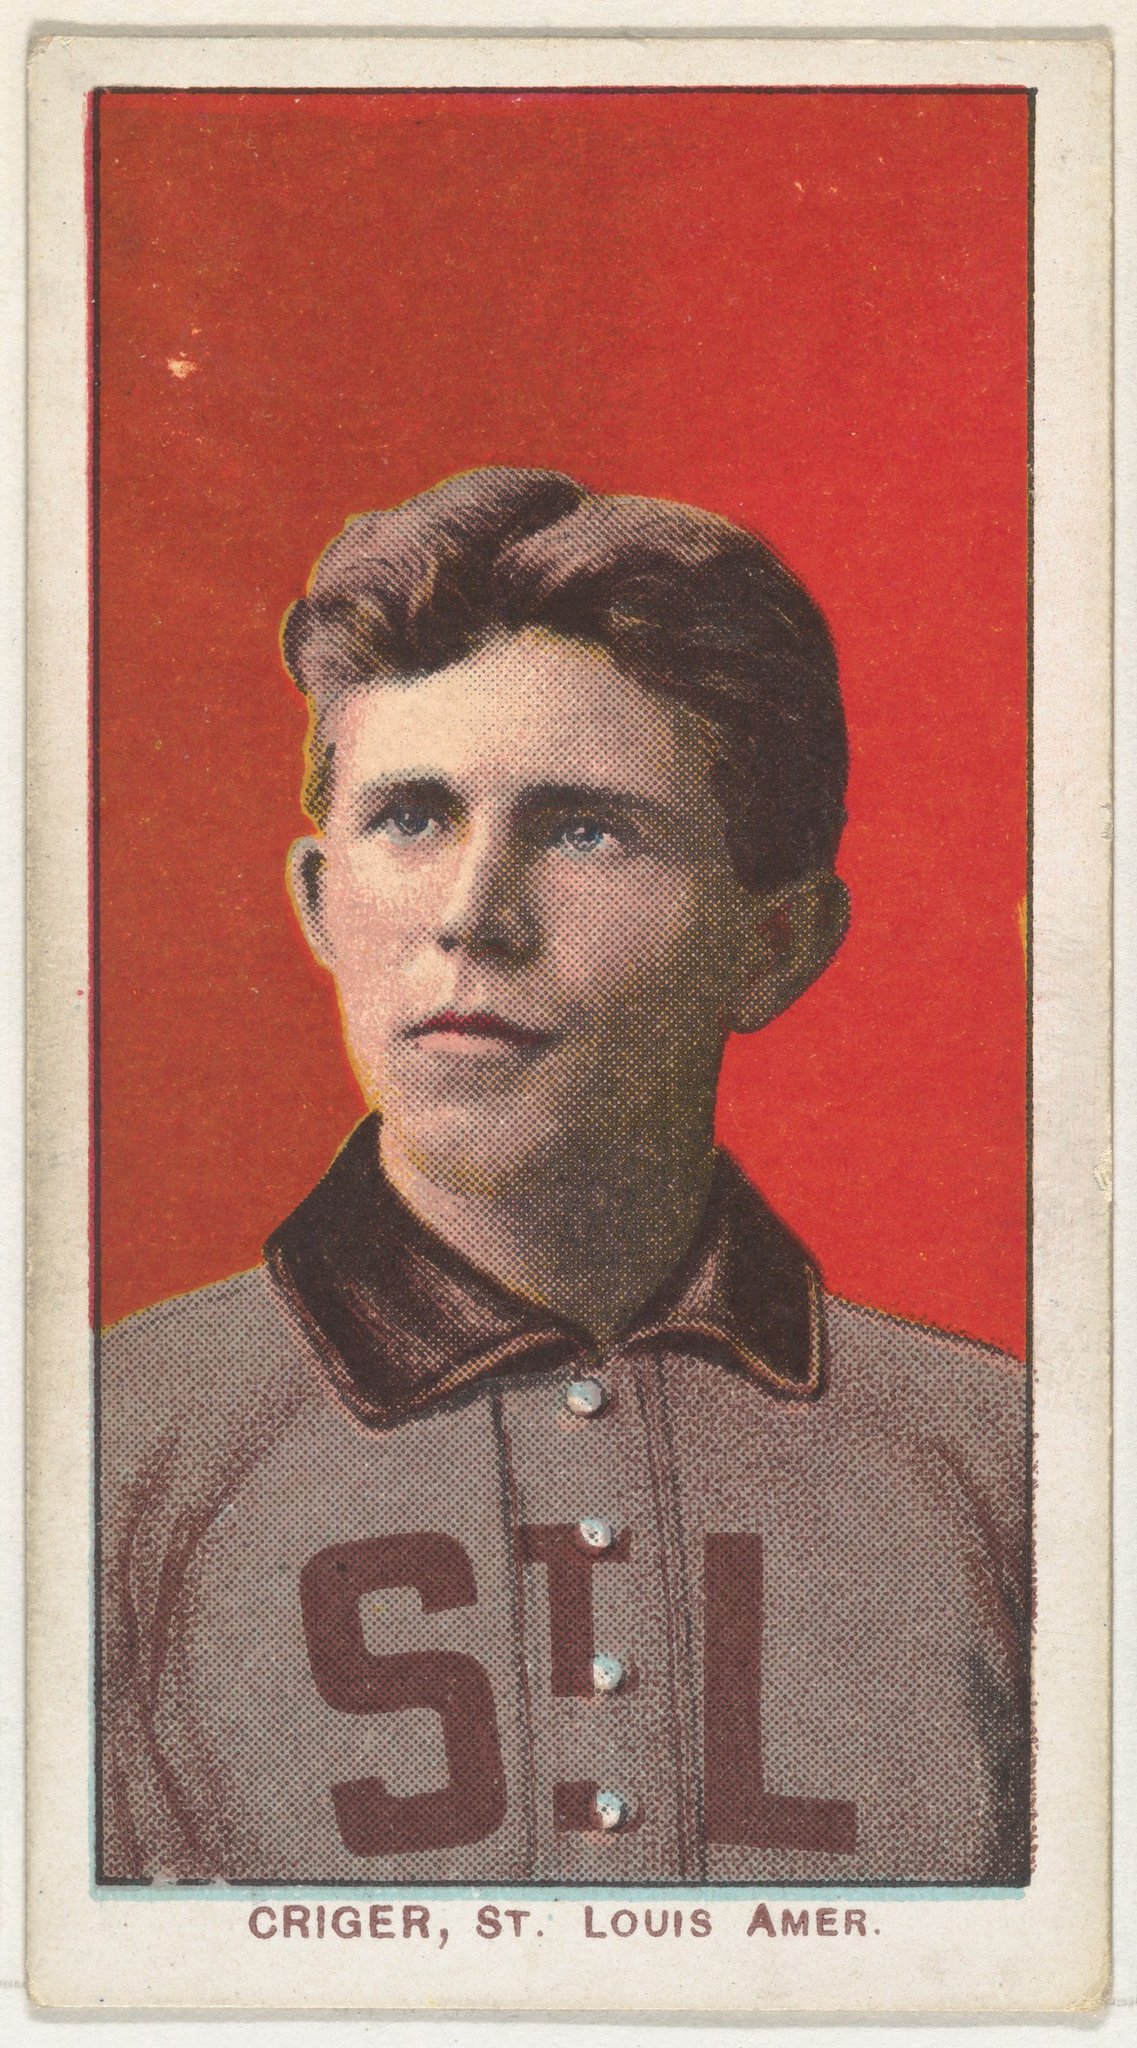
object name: baseball card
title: Criger, St. Louis, American League, from the White Border series (T206) for the American Tobacco Company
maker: american tobacco company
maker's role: publisher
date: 1909-1911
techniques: lithography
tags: men,portraits,baseball,athletes